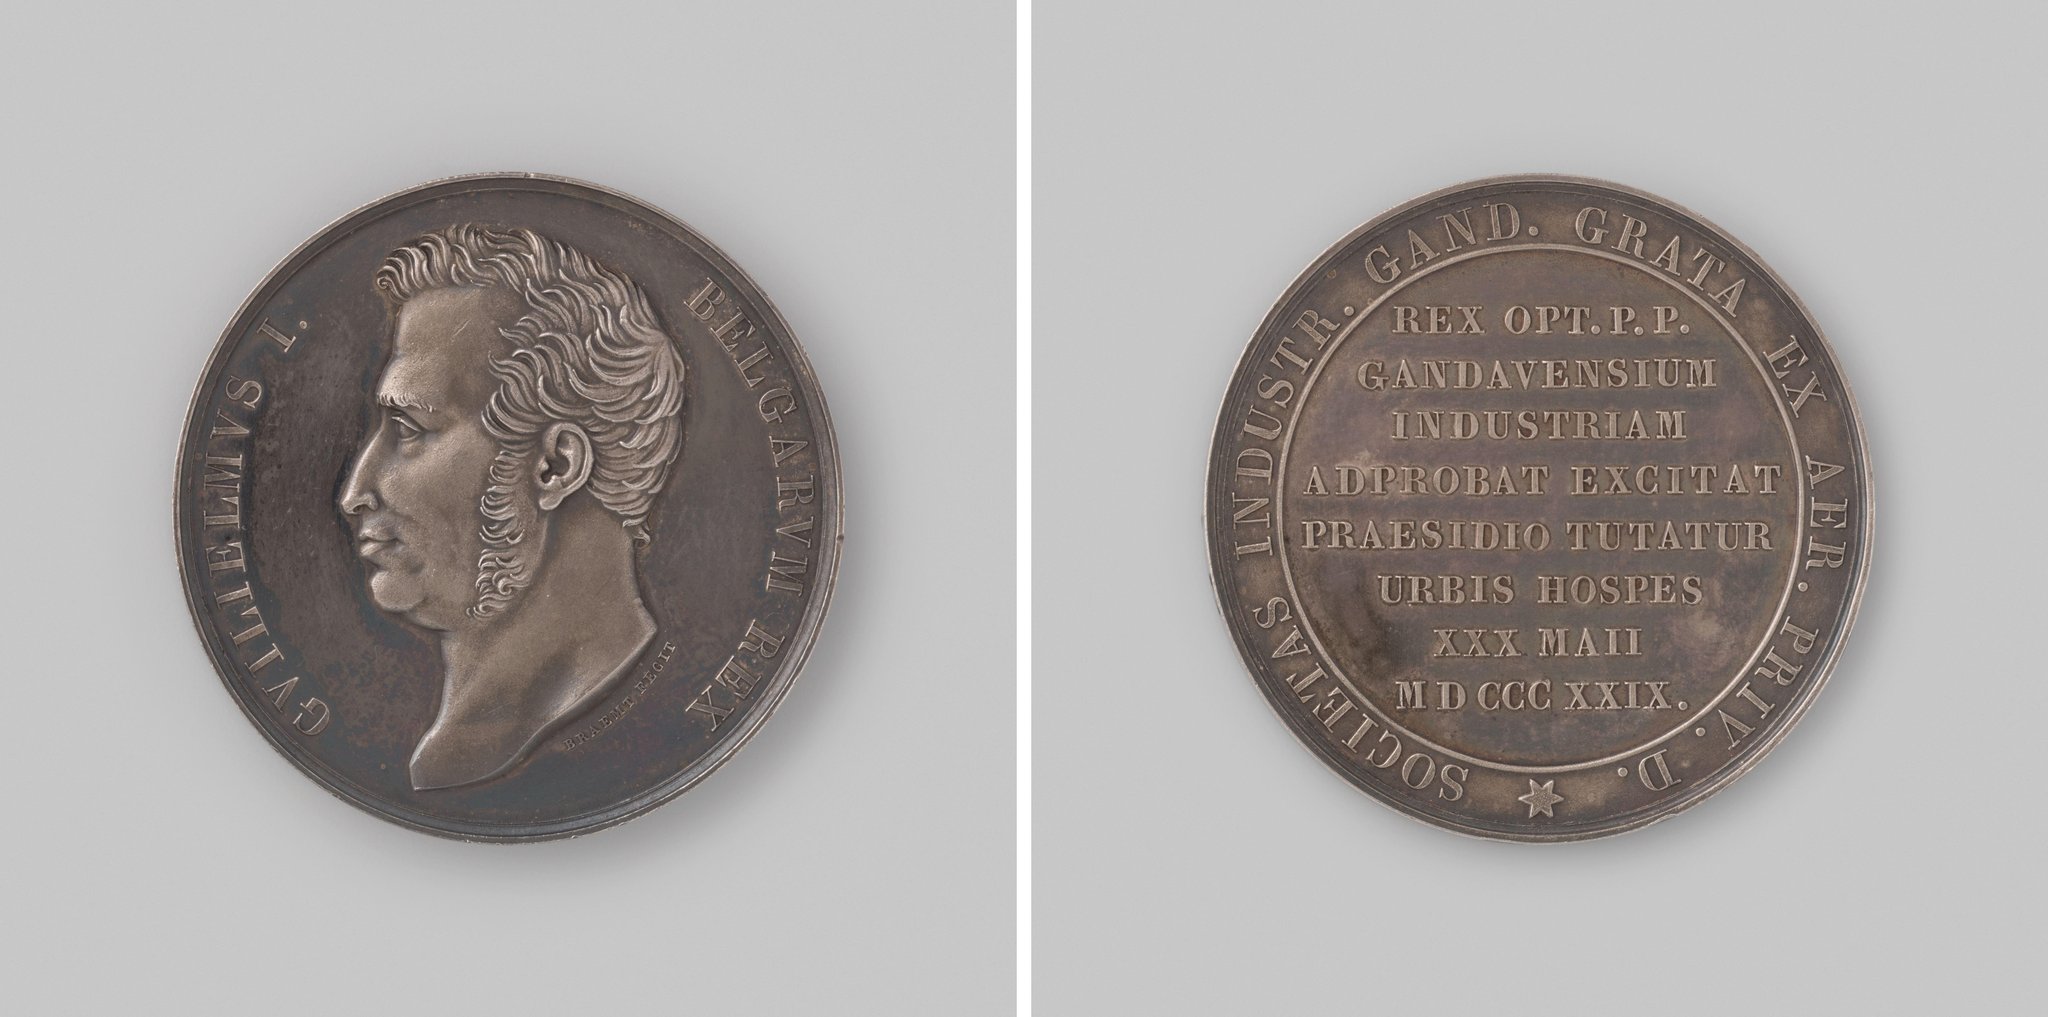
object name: history medal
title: Bezoek van Willem I Frederik, koning der Nederlanden aan Gent, penning geslagen op last van de Maatschappij van Nijverheid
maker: joseph pierre braemt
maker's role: print maker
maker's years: 1796-1864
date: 1829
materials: silver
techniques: striking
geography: brussels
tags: the hague, berlin, william i of the netherlands, ghent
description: Zilveren penning. Voorzijde: borststuk man binnen omschrift. Keerzijde: opschrift binnen omschrift